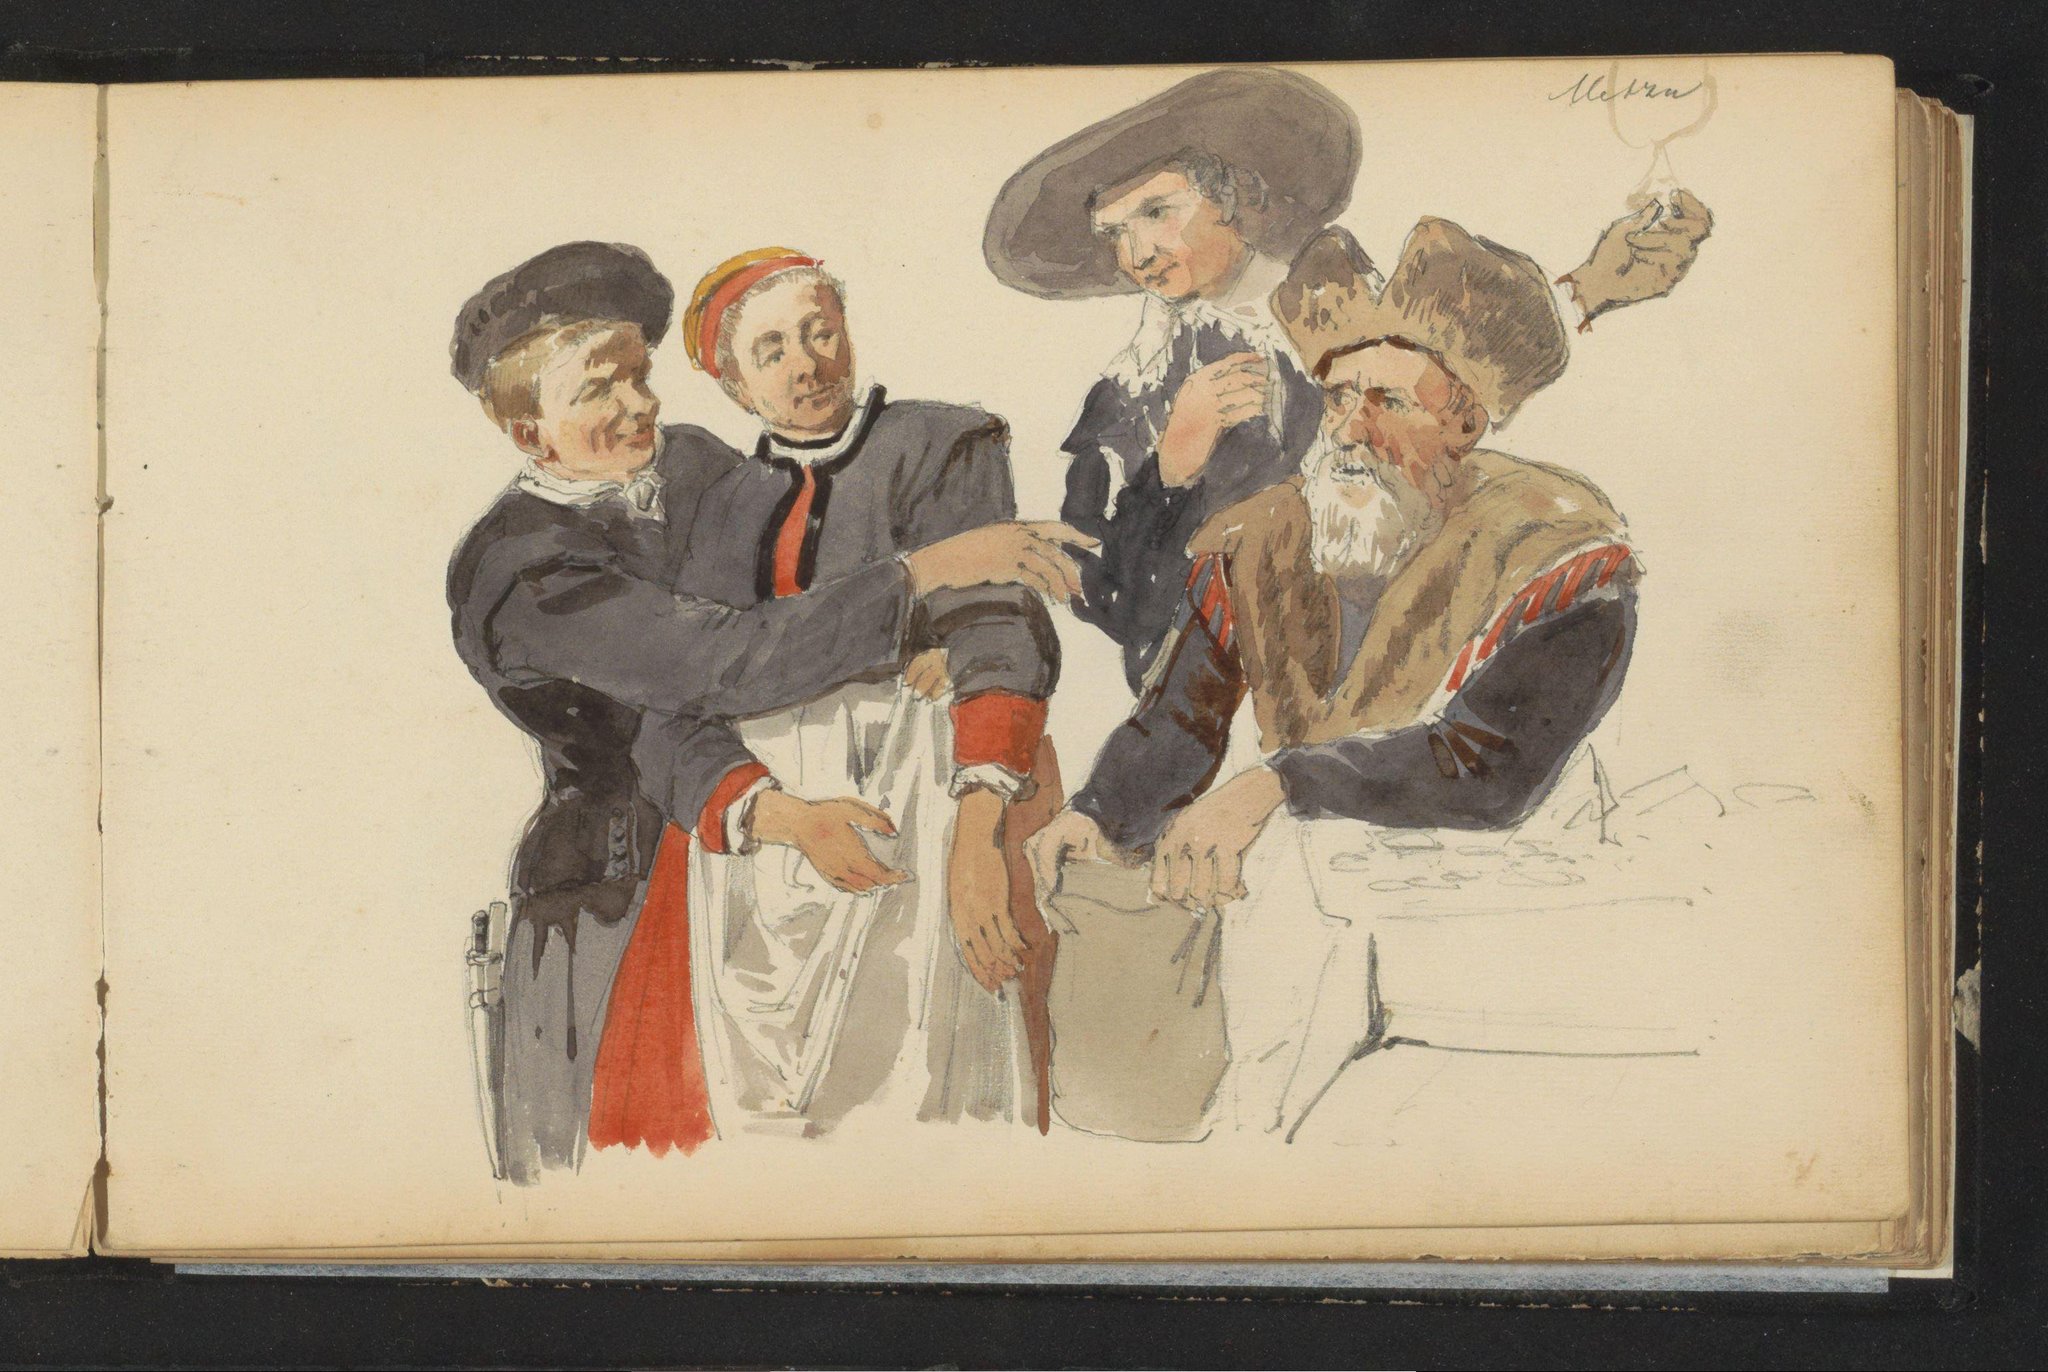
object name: sketchbook leaf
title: Gezelschap in zeventiende-eeuwse kleding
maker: cornelis springer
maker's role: draughtsman, painter, print maker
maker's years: 1817-1891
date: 1846-1882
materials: paper, pencil, watercolor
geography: amsterdam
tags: adult woman, adult man, clothes, costume (+ women's clothes), clothes, costume (+ men's clothes), young versus old age; young and old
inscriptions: annotation: ‘Metzu’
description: Mooi Aal of 'De keuze tussen jong en oud'. Een jonge vrouw wendt zich af van een rijke oude man en een jonge man en kiest voor een jongen die spottend naar zijn mededingers wijst. De oude man draagt een bontmuts en zit aan een tafel geldstukken te tellen. Hij houdt een geldzak geopend. Voorgesteld zijn waarschijnlijk vier hoofdrolspelers uit het toneelstuk 'Het spel van de Moor' van G.A. Bredero (van links naar rechts): Kackerlack, Mooi Aal, Ritsert en Roemert. Blad 32 uit een schetsboek met 91 bladen.